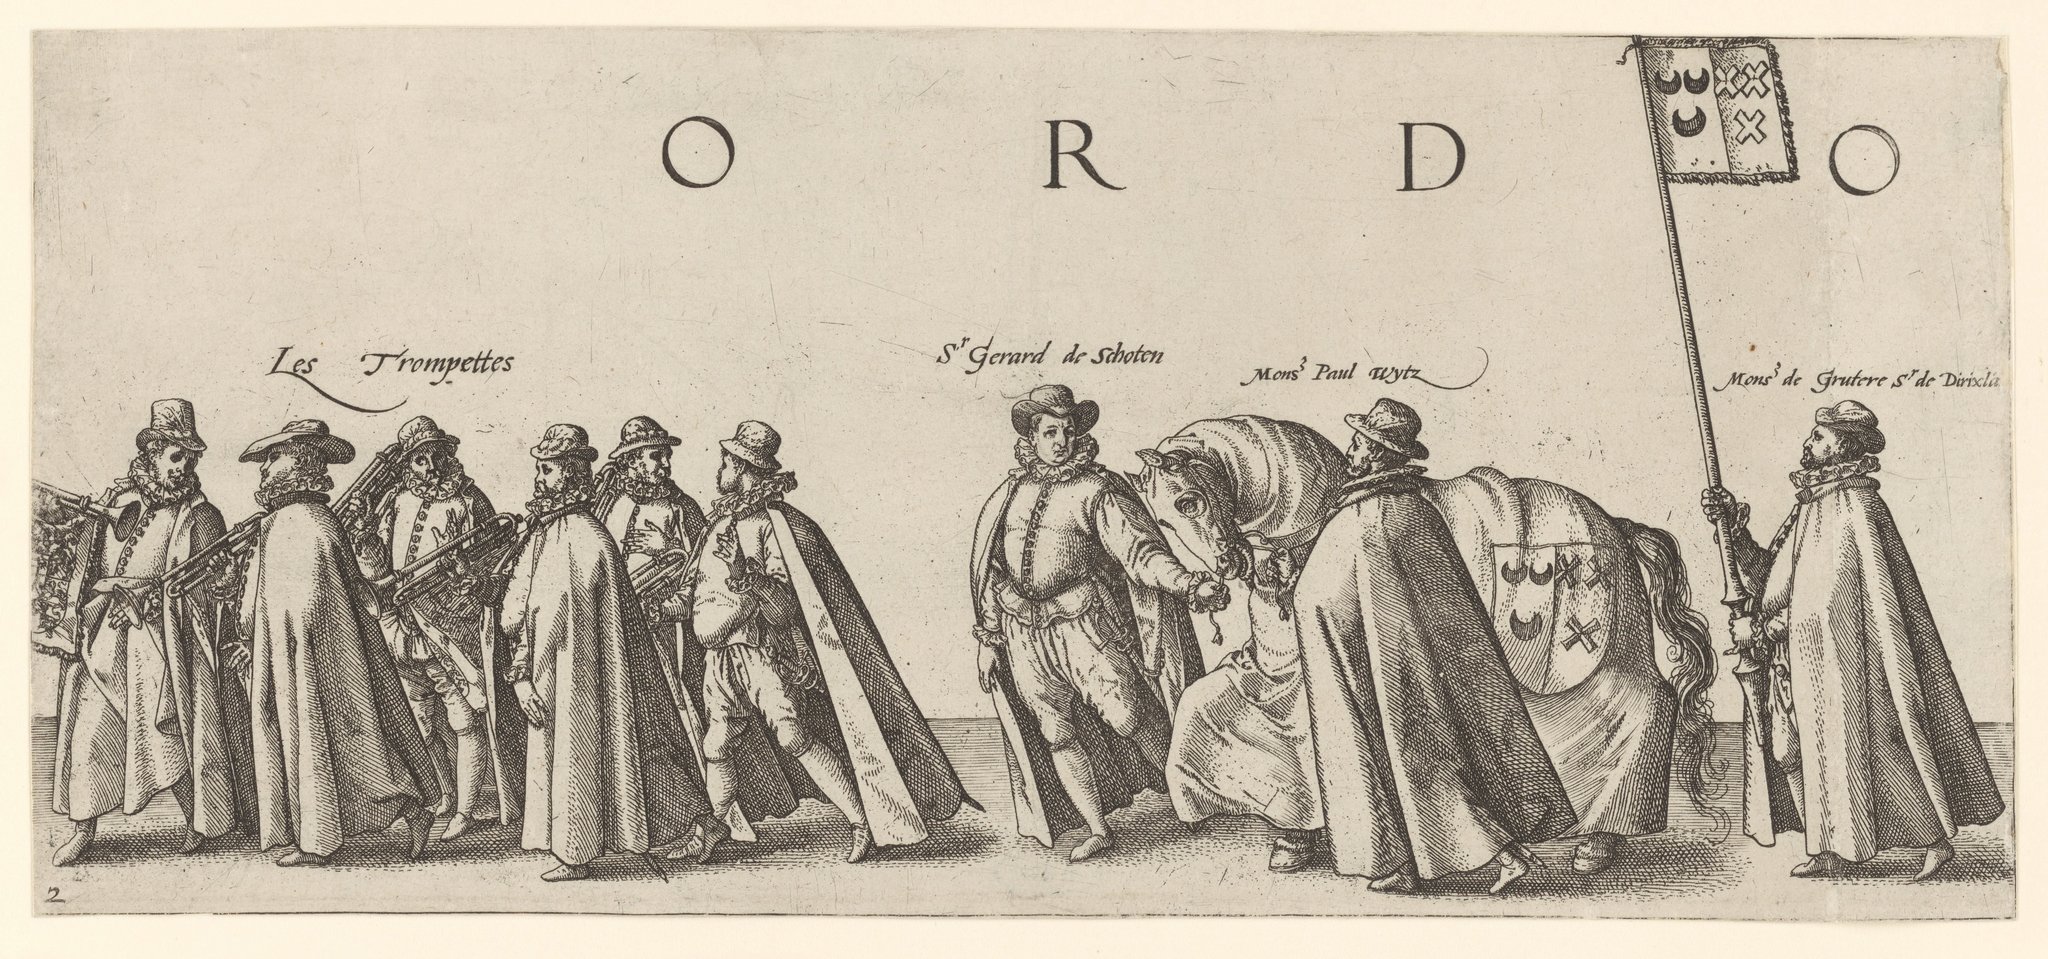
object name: print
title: Begrafenisstoet van Willem van Oranje, blad 2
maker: hendrick goltzius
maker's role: draughtsman, painter, print maker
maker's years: 1558-1617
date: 1584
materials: paper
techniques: engraving, etching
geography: haarlem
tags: delft, william i (prince of orange), cortege, funeral procession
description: Lijkstatie met de zes trompetters, Gerard van Schoten en Paul Wytz met een paard met het wapen en De Grutere met het vaandel van Polanen-Breda. Blad 2 in de begrafenisstoet van Willem van Oranje, Delft 3 augustus 1584.